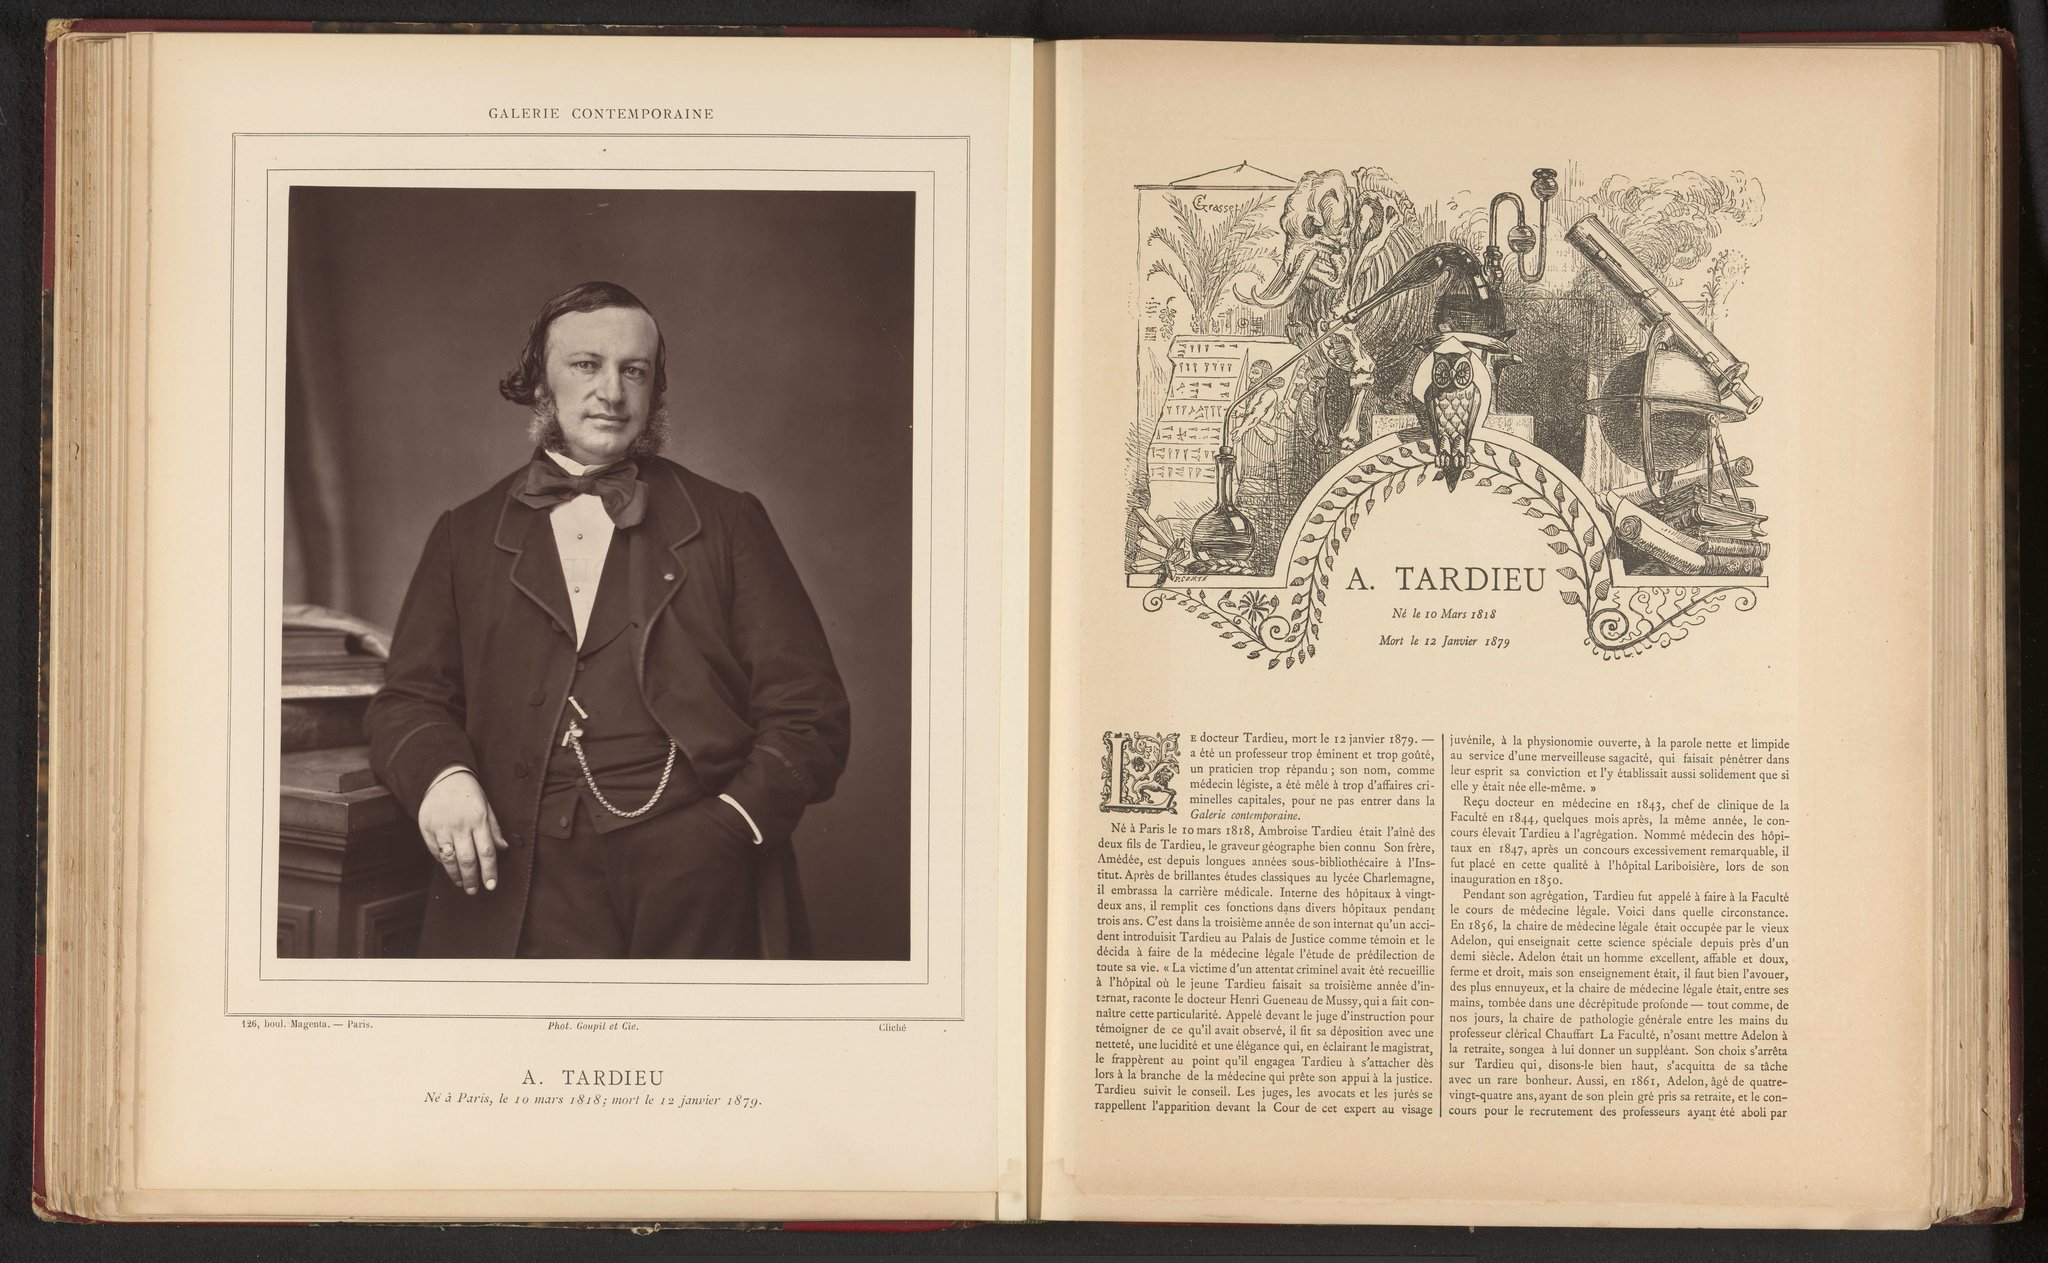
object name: page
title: Portret van Auguste Ambroise Tardieu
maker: Anonymous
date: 1876-1879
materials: paper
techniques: woodburytype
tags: physician, doctor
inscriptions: inscription: ‘126, boul. Magenta.-Paris.’